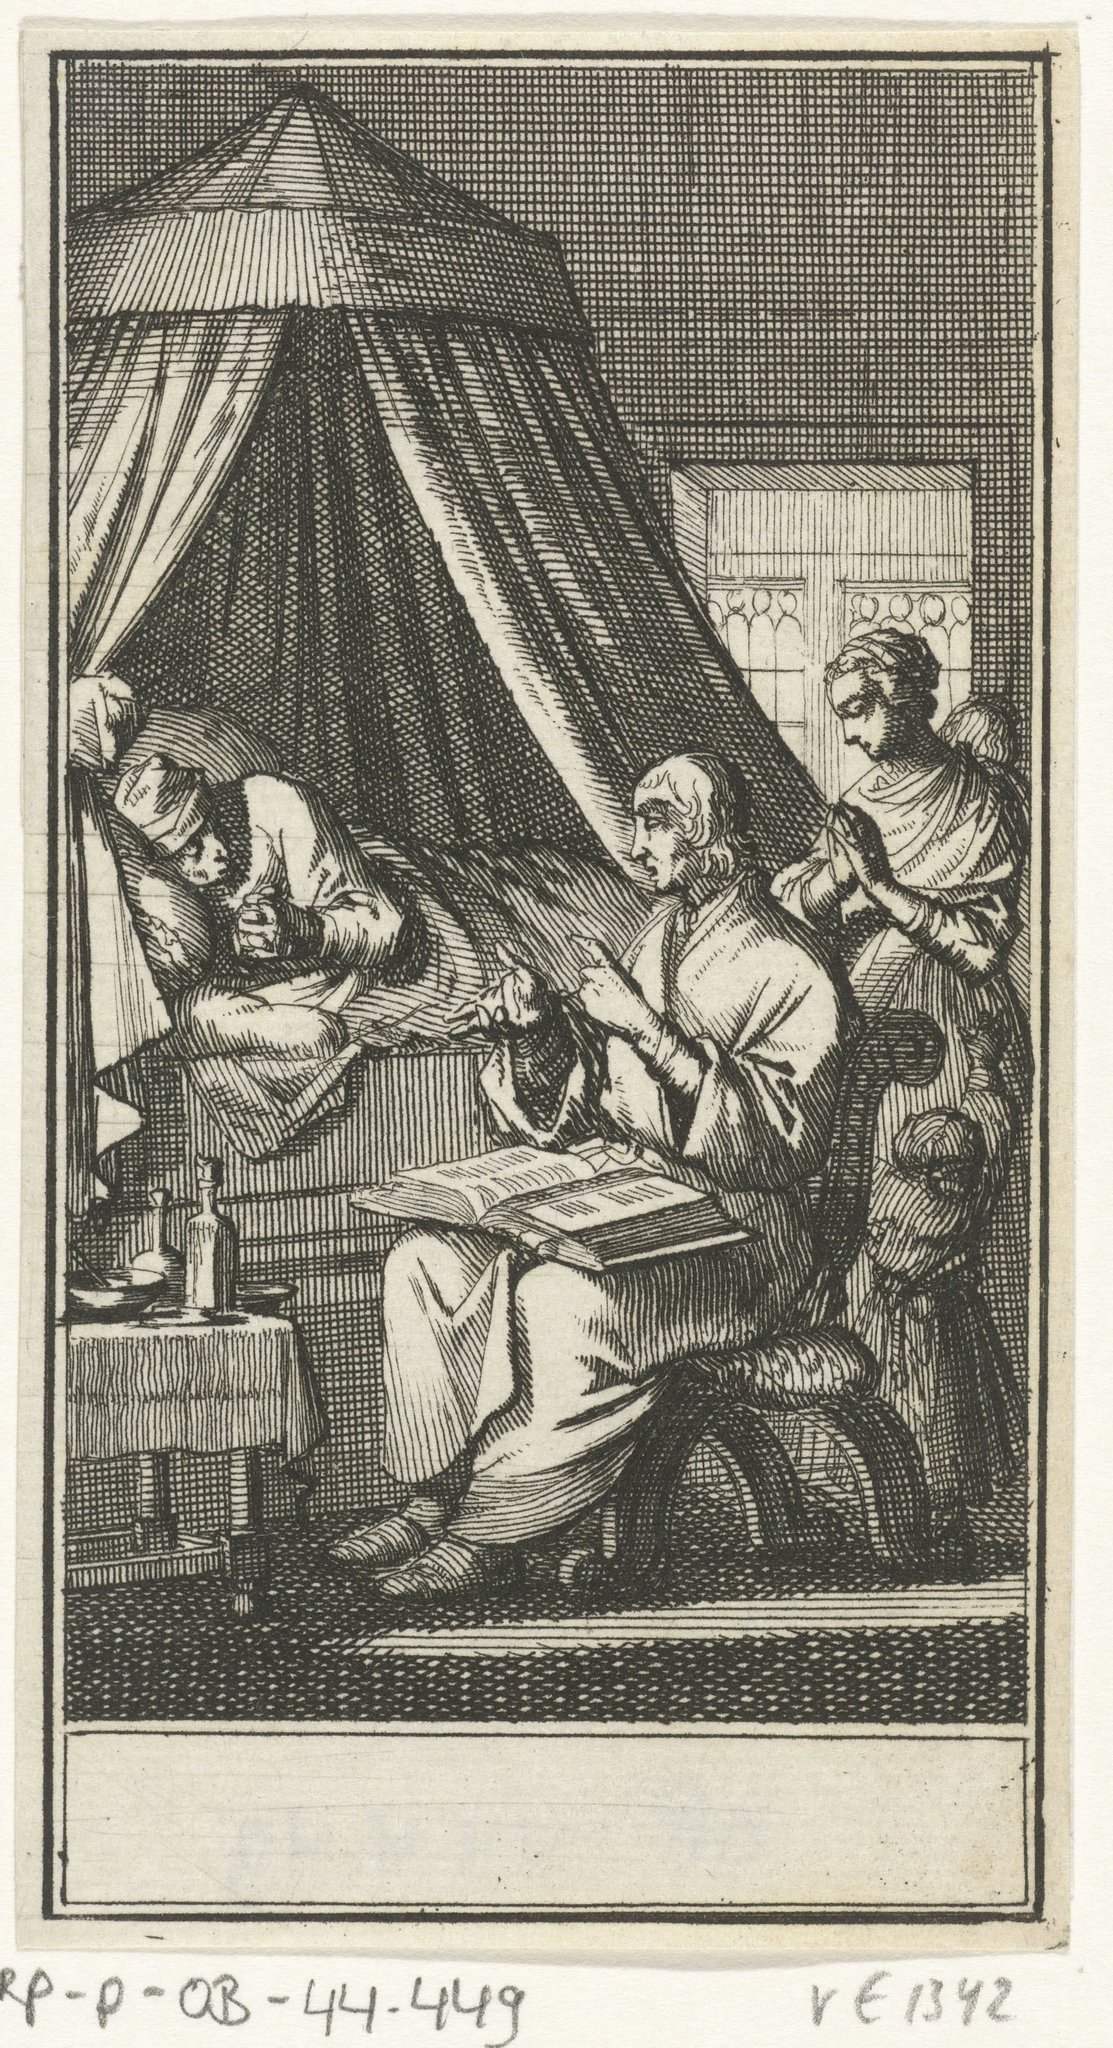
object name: print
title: Biddende figuren aan het bed van een zieke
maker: jan luyken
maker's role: draughtsman, print maker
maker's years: 1649-1712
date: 1693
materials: paper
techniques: etching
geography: amsterdam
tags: one person praying, visiting the sick; sick person together with others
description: Voltooide staat opgenomen in: Molinaeus, Johannes. Sleutel des hemels ofte Christelyk gebede-boek. Amsterdam: Barent Bos, 1693 (en latere drukken van dit werk).